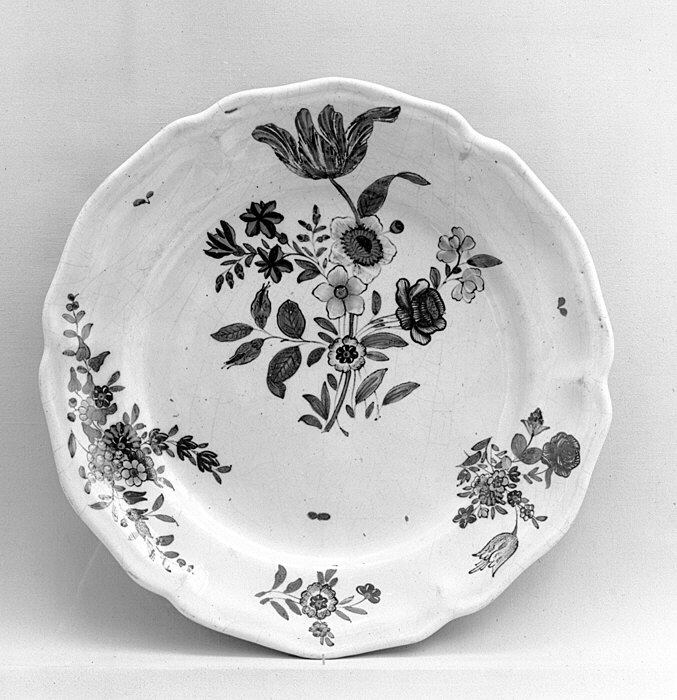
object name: plate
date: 1701-1800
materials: faience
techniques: glazing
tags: flowers